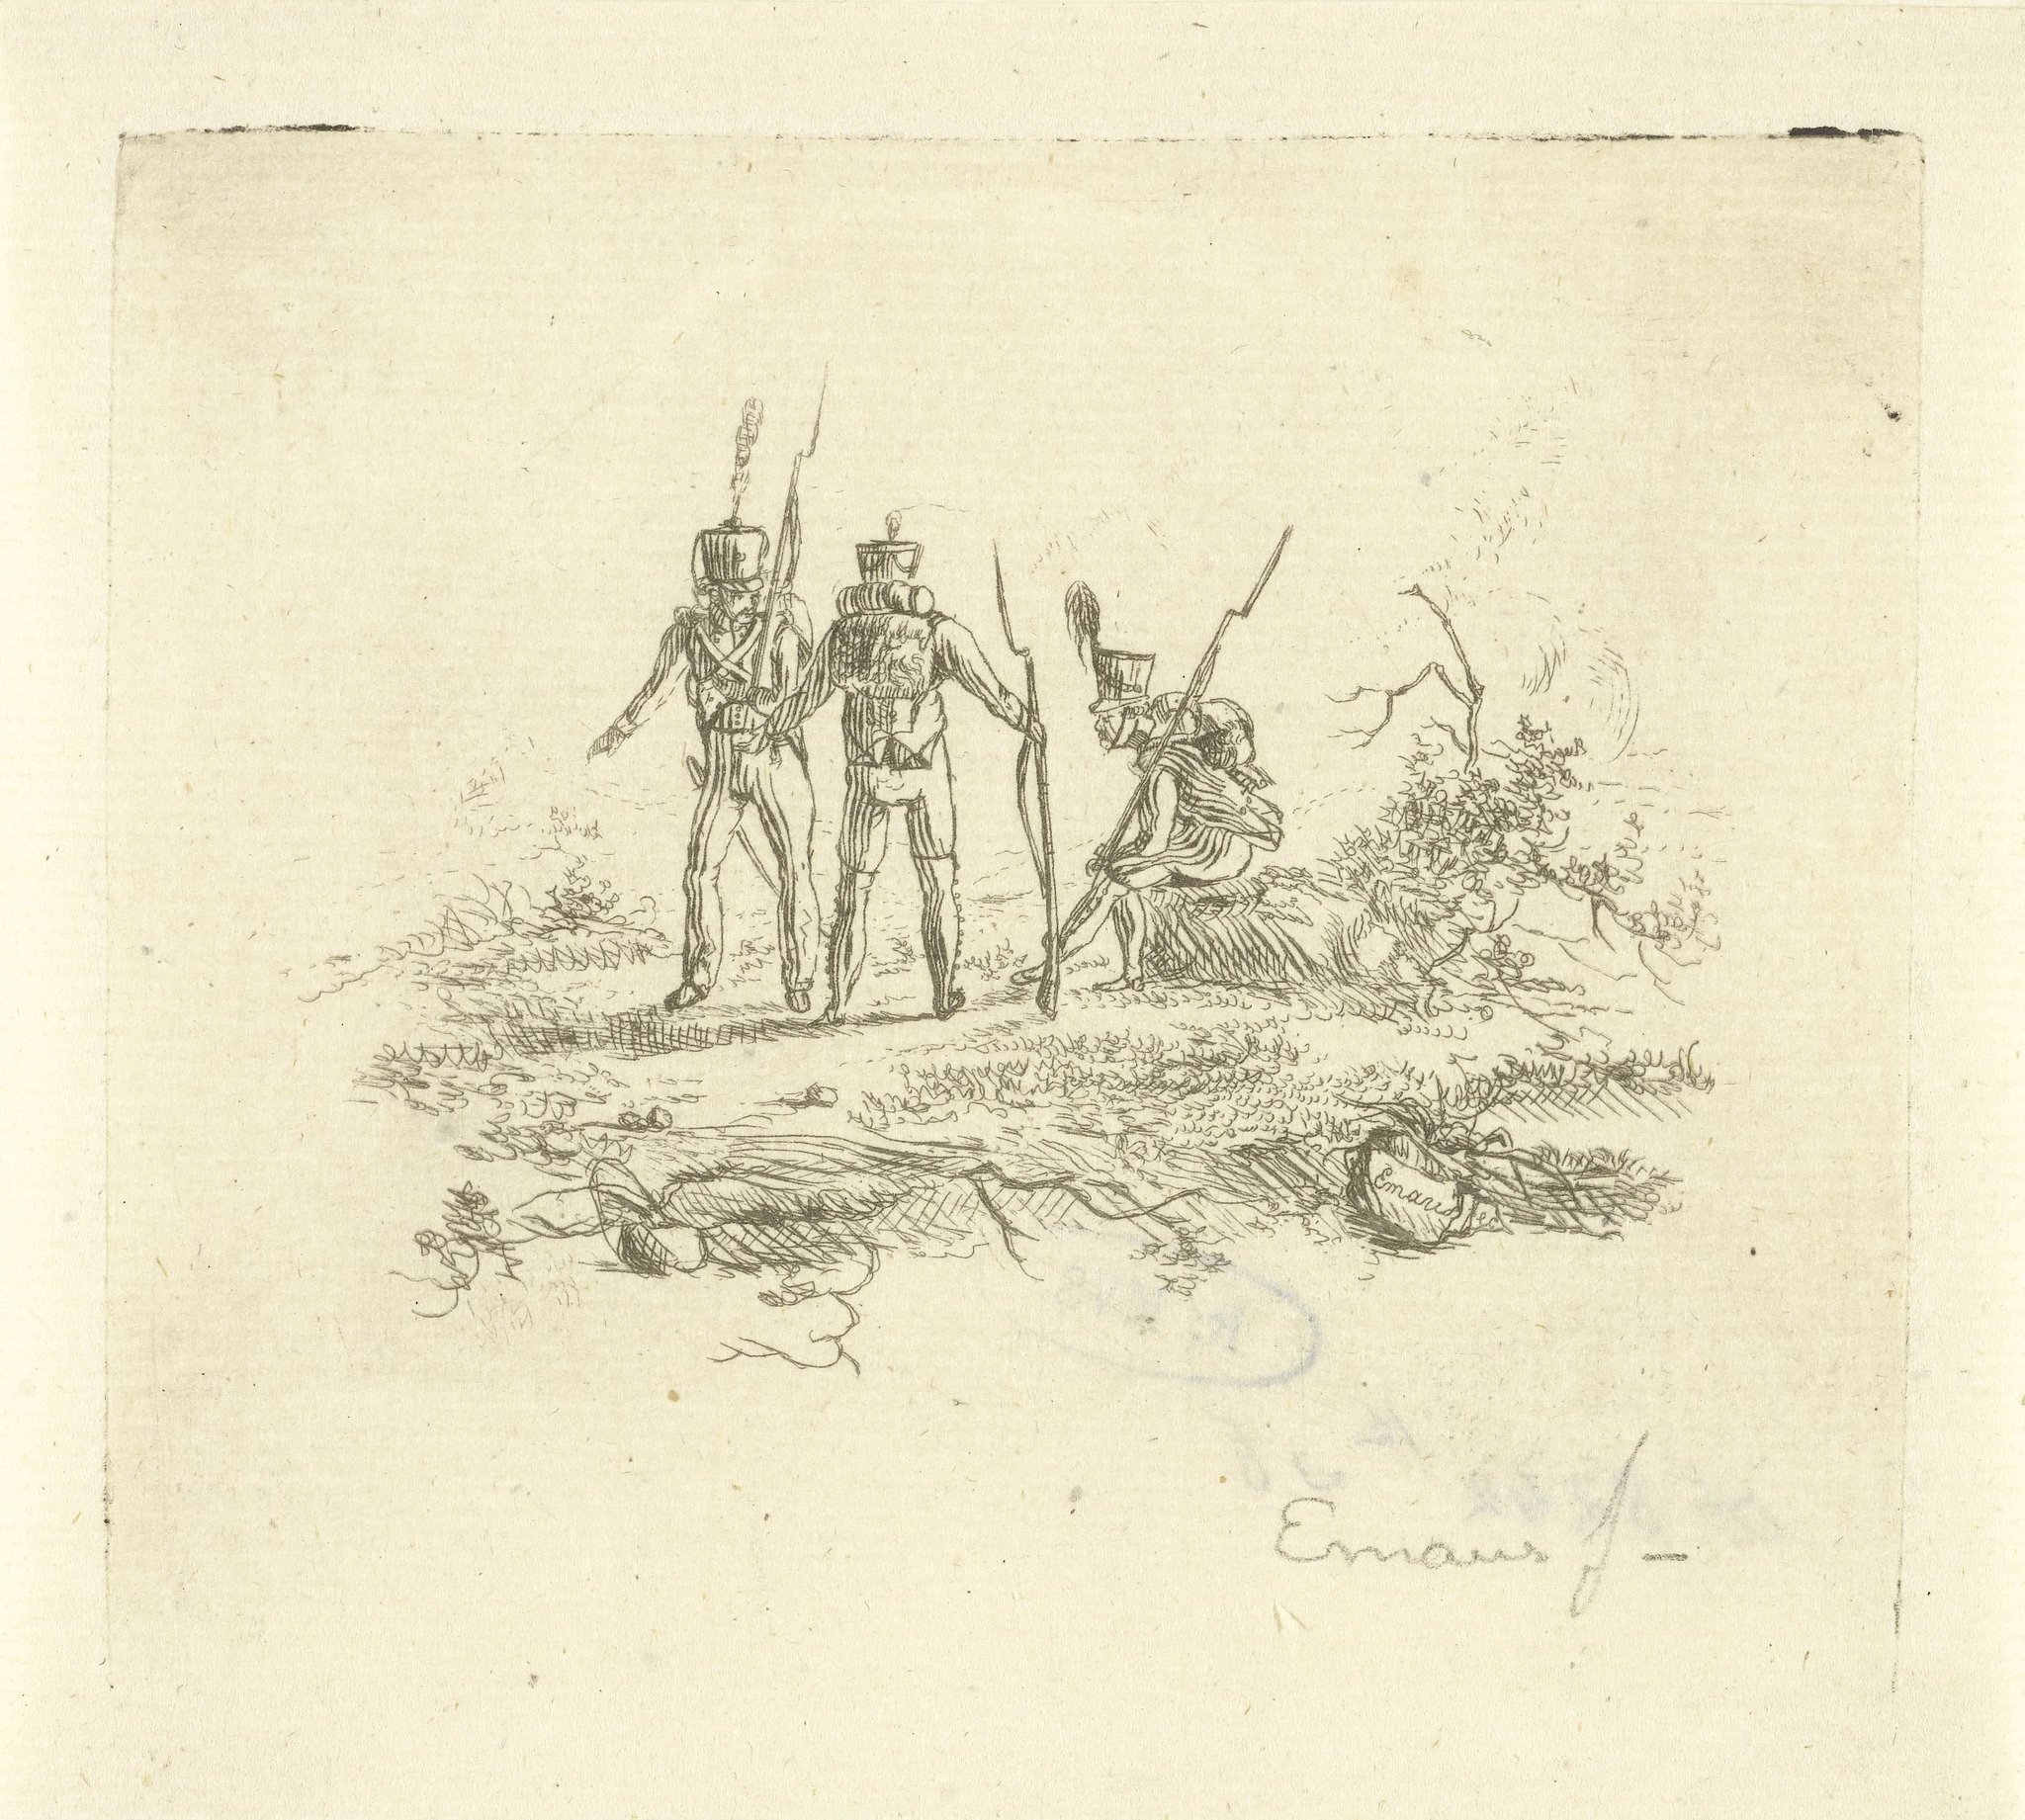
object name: print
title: Drie infanteristen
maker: gerardus emaus de micault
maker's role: draughtsman, print maker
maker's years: 1798-1863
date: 1813-1863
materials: paper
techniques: etching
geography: netherlands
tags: the soldier; the soldier's life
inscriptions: collector's mark: Lugt 2228